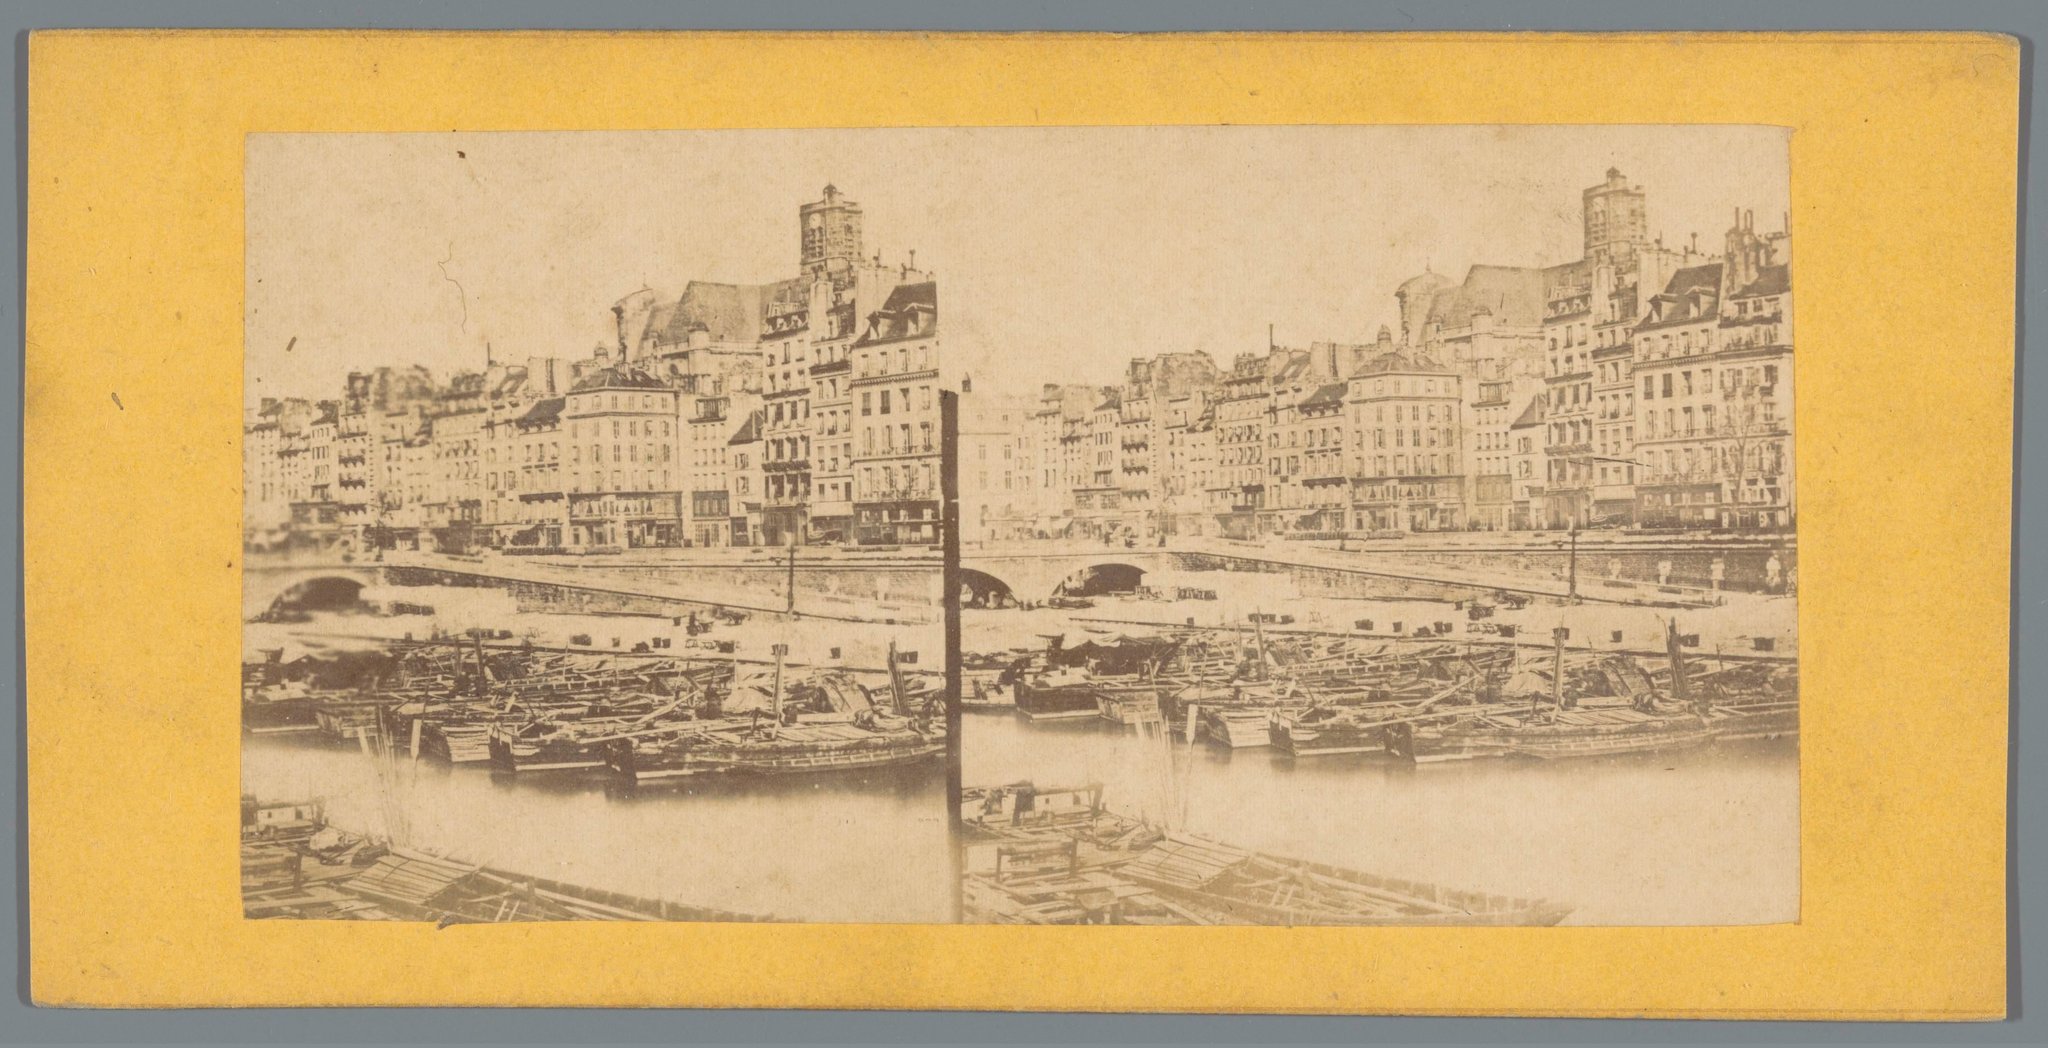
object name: stereograph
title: Gezicht op een kade in Parijs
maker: Anonymous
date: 1850-1880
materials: cardboard, photographic support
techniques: albumen print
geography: paris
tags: quay, paris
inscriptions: inscription: ‘[...] N: 29 Saint Gervais (rive droit) en nieuwe Pont Saint-[...](?) na vervanging in 1861 van Pont Louis Philip’